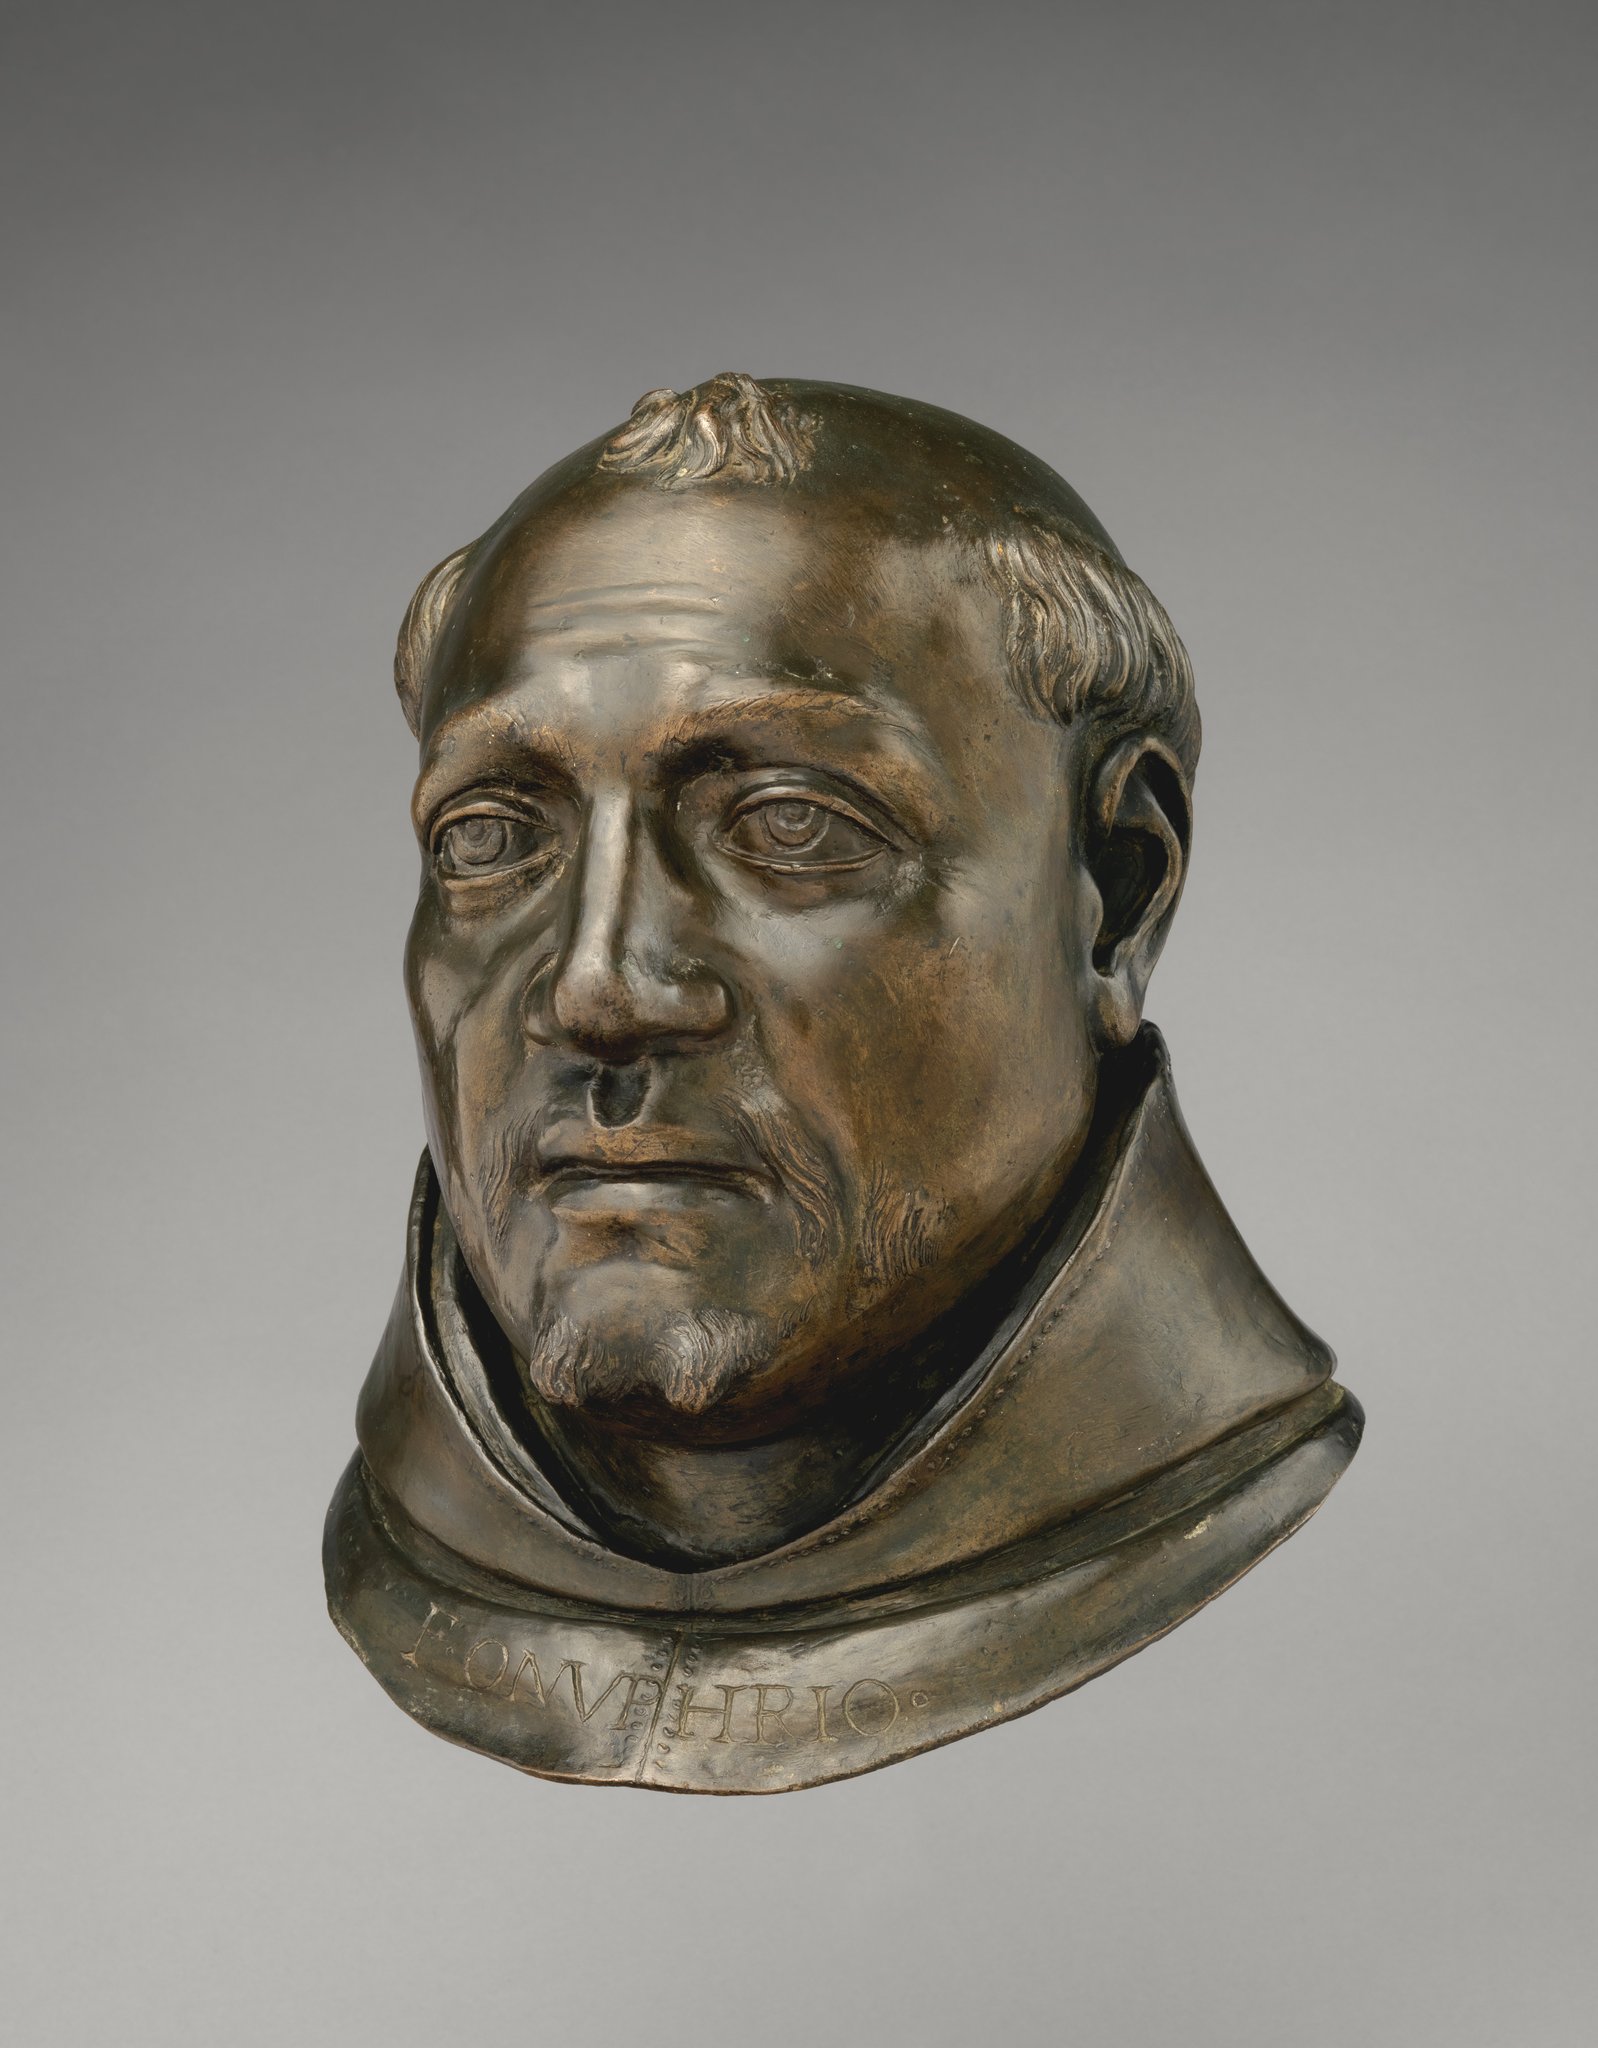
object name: head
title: Onofrio Panvinio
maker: girolamo campagna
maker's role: artist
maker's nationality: italian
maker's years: 1549-1625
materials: bronze, iron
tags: heads,men